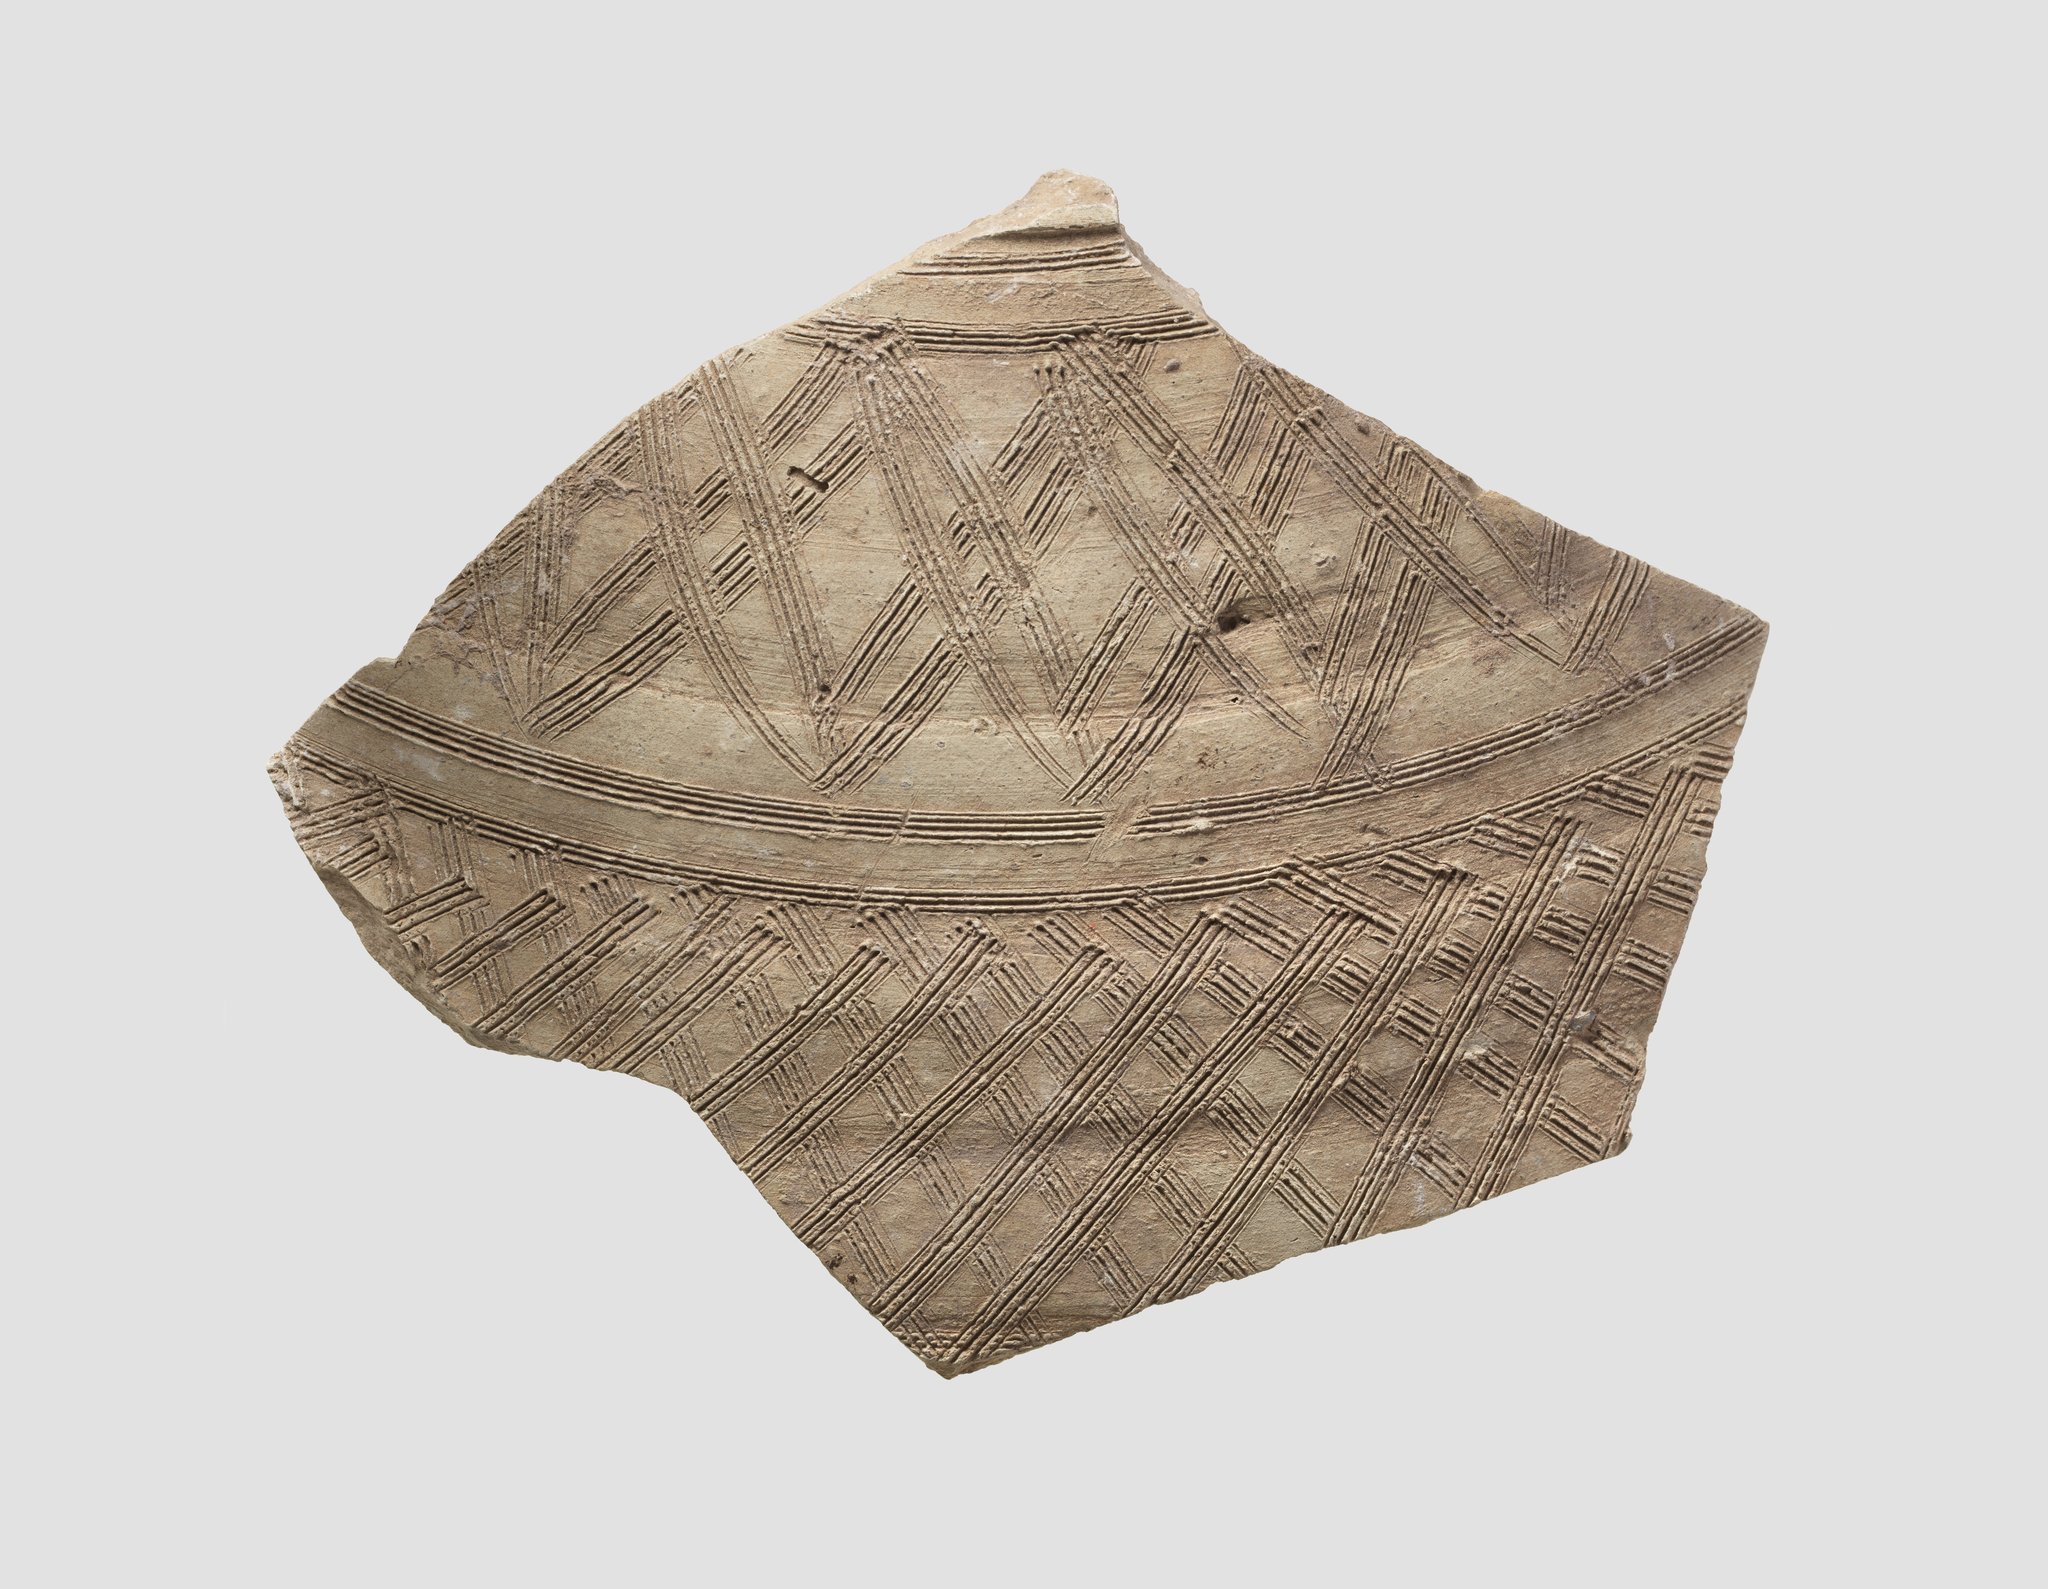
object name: sherd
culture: sasanian or islamic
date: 501-800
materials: ceramic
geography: mesopotamia